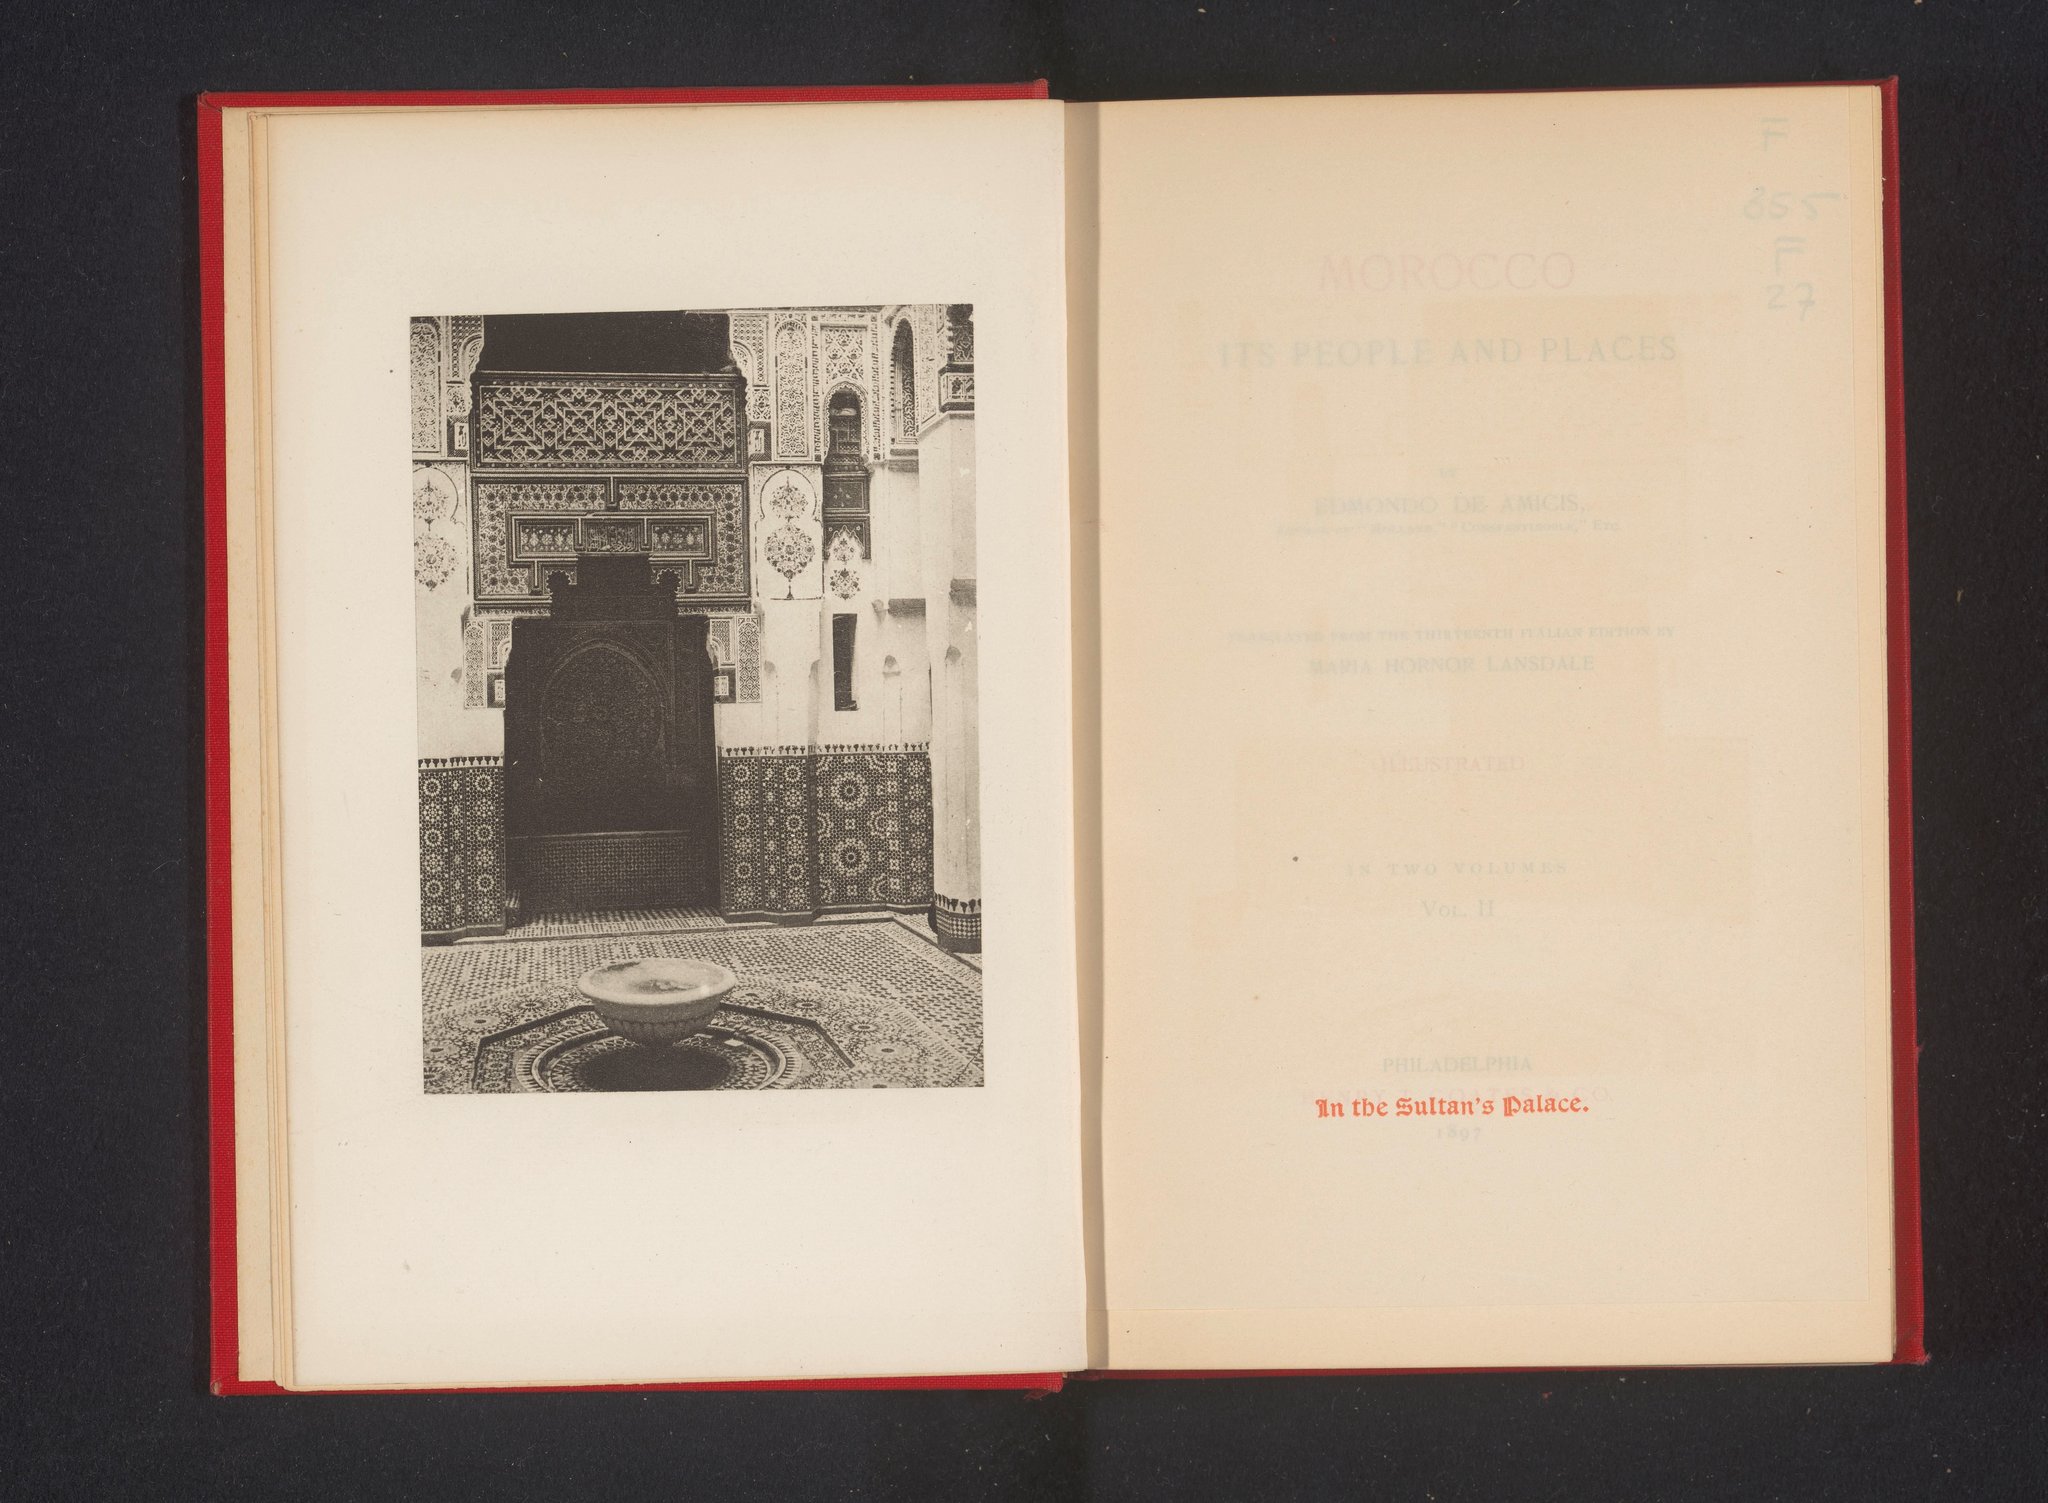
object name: page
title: Binnenplaats van (vermoedelijk) het Bahiapaleis te Marrakech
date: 1887-1897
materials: paper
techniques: photoaquatint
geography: marrakech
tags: ornamental fountain, inner court of palace or 'hôtel'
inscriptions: title: ‘In the Sultan's Palace.’